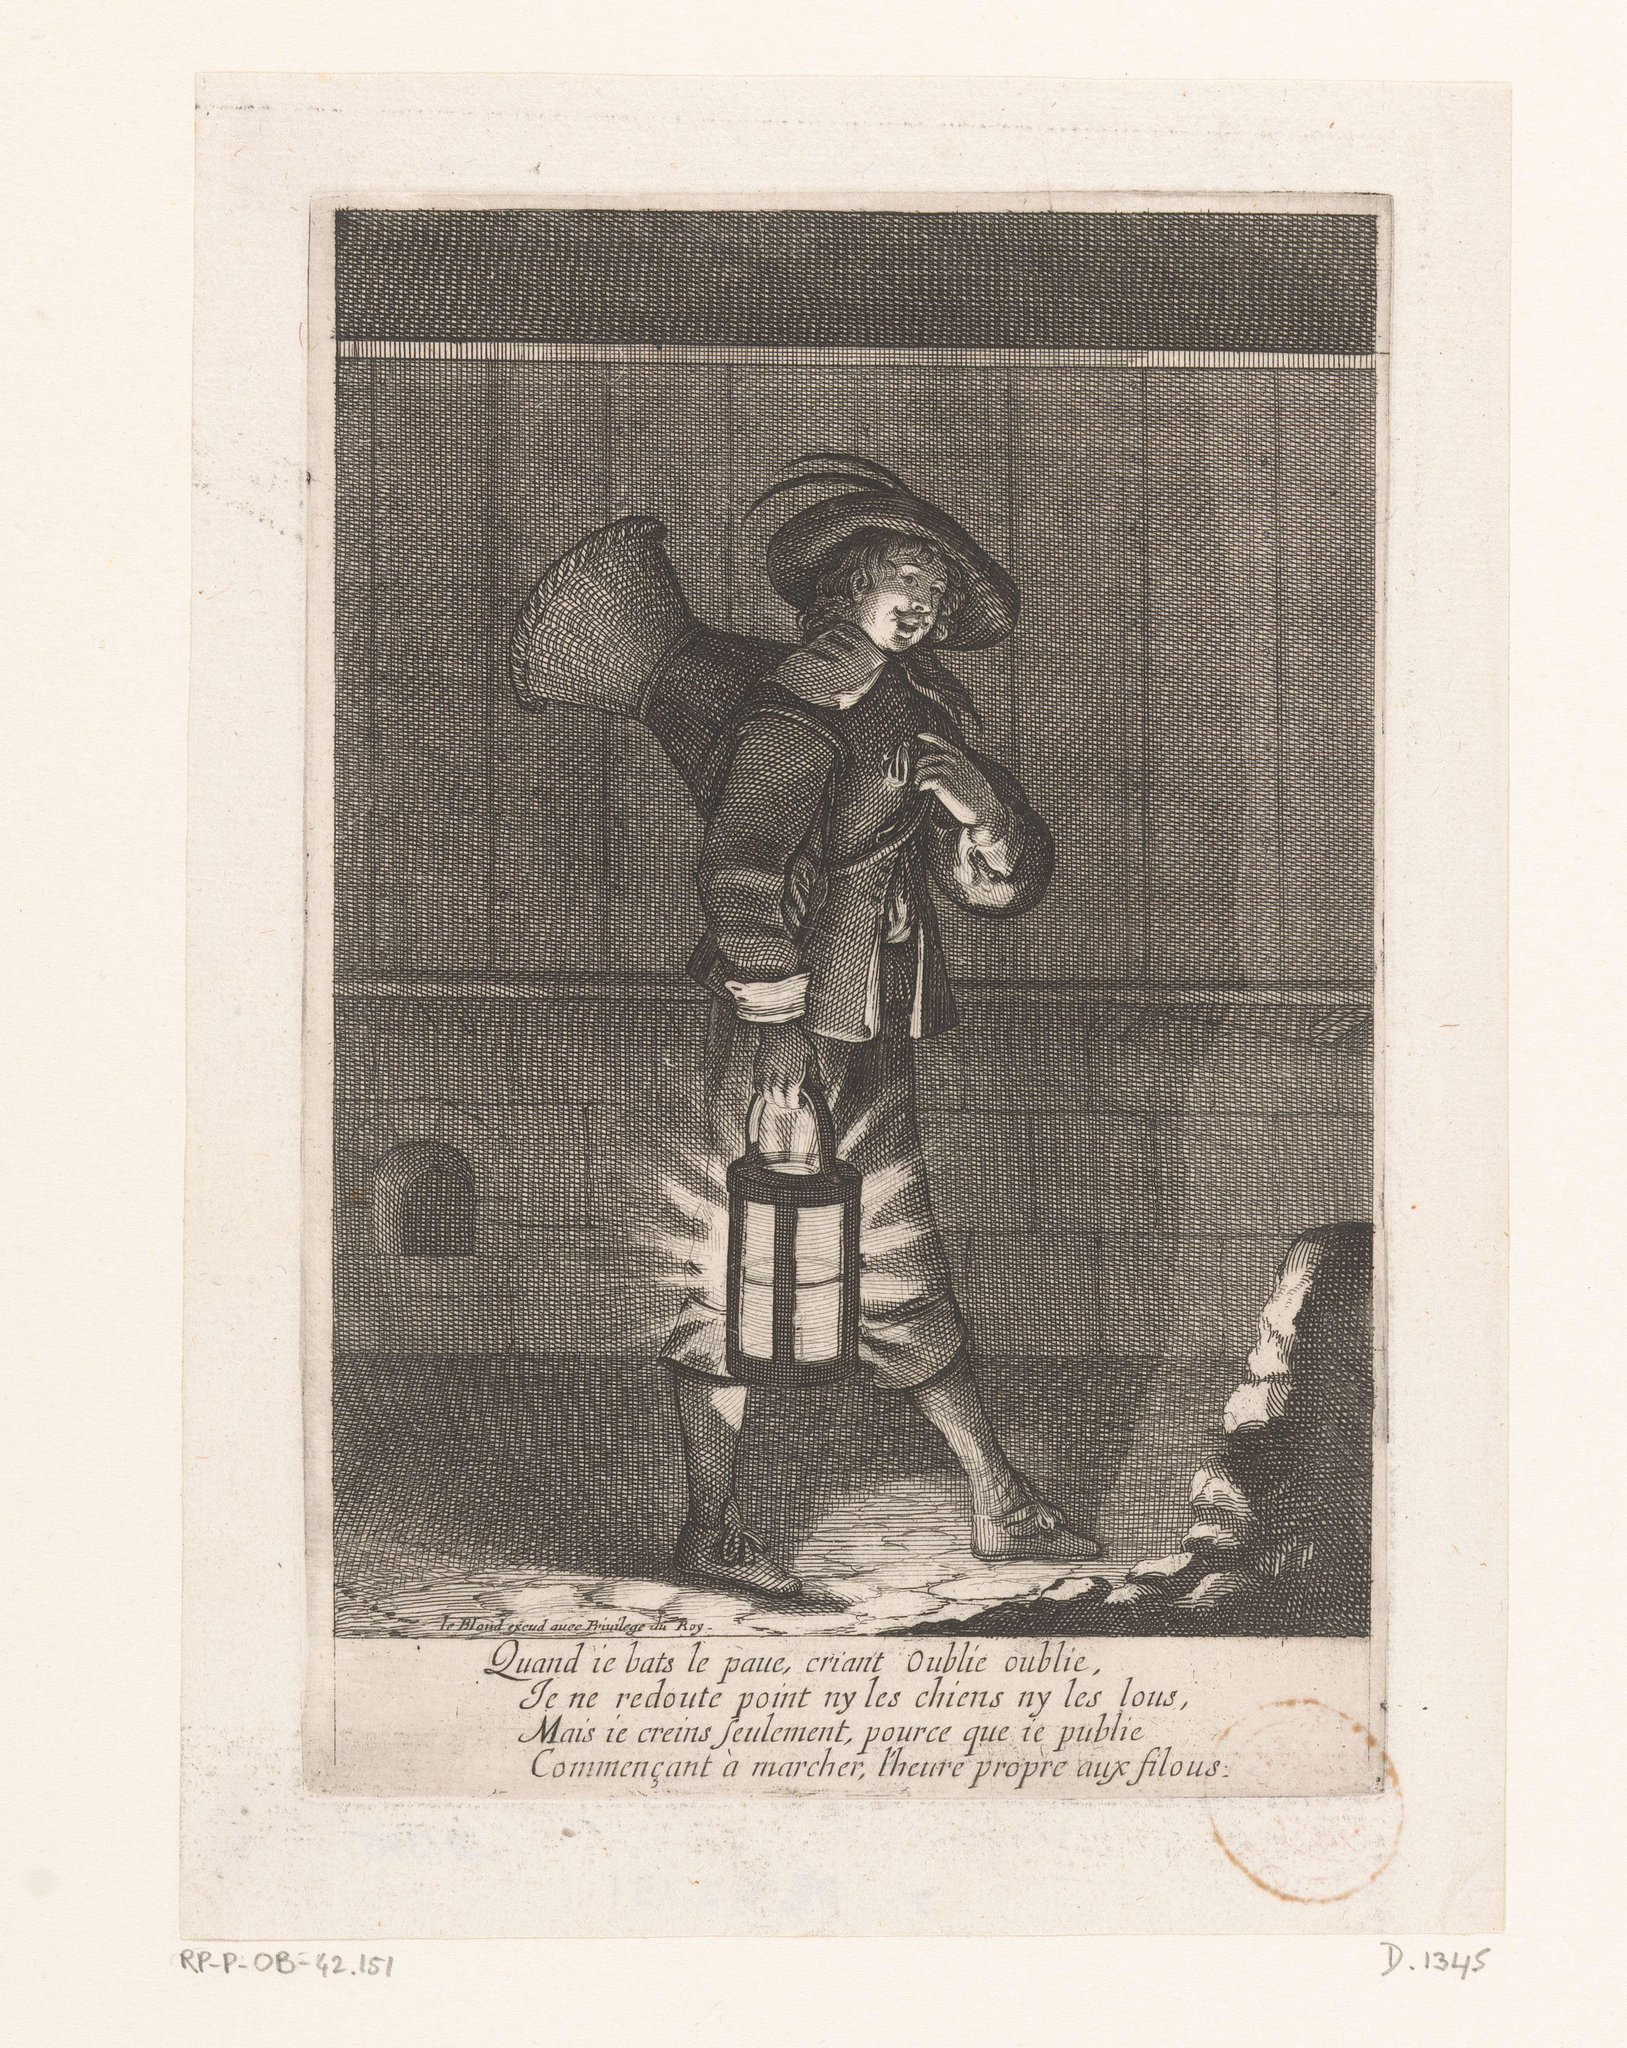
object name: print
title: Les cris de Paris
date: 1629-1630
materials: paper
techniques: engraving, etching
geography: paris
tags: cake, tart, pastry, wandering or travelling merchant, merchant, salesman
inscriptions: collector's mark: Lugt 240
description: Maakt deel uit van een serie van twaalf prenten met straatverkopers en dienstverleners, uitgegeven door Jean Leblond (I) tussen 1629-1630 te Parijs.